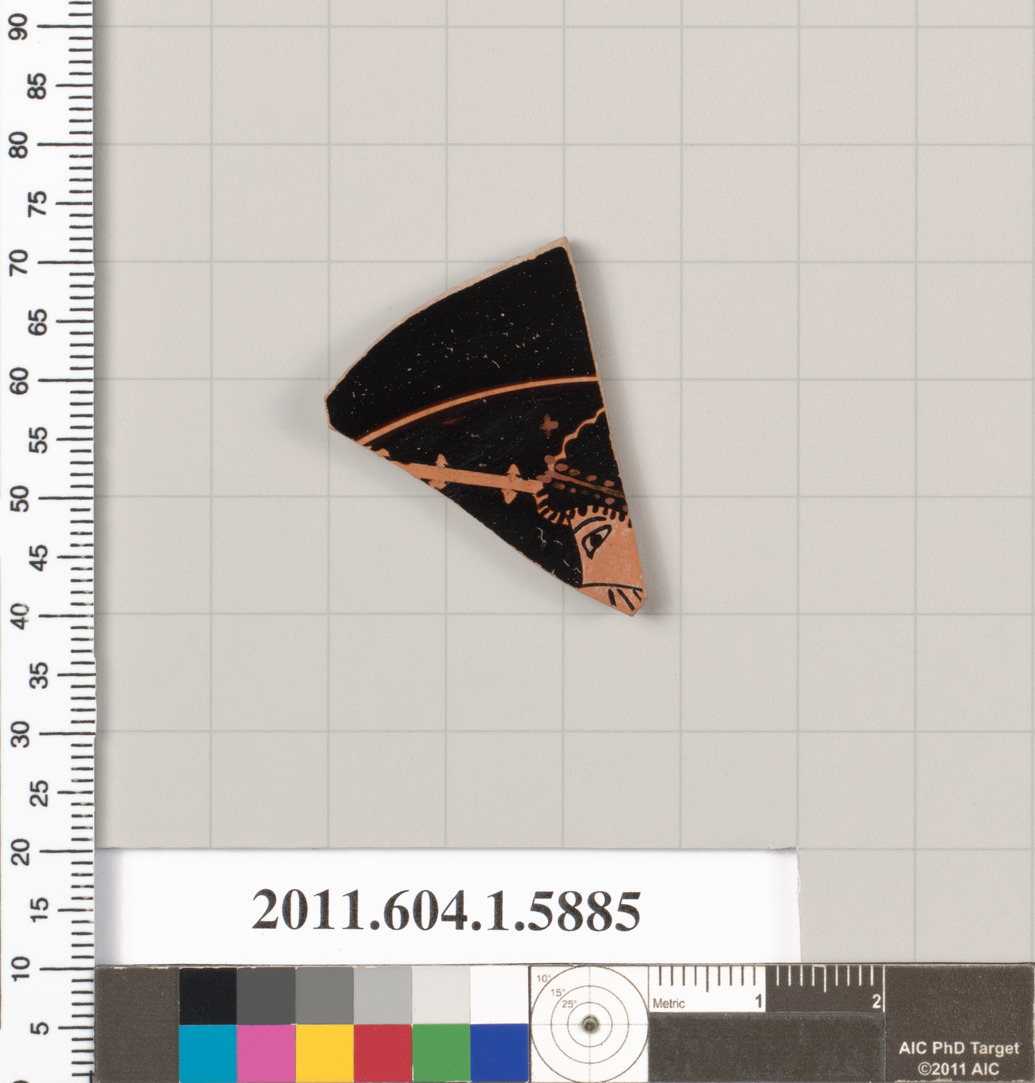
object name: kylix fragment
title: Terracotta fragment of a kylix (drinking cup)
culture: greek, attic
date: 520-510 BCE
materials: terracotta